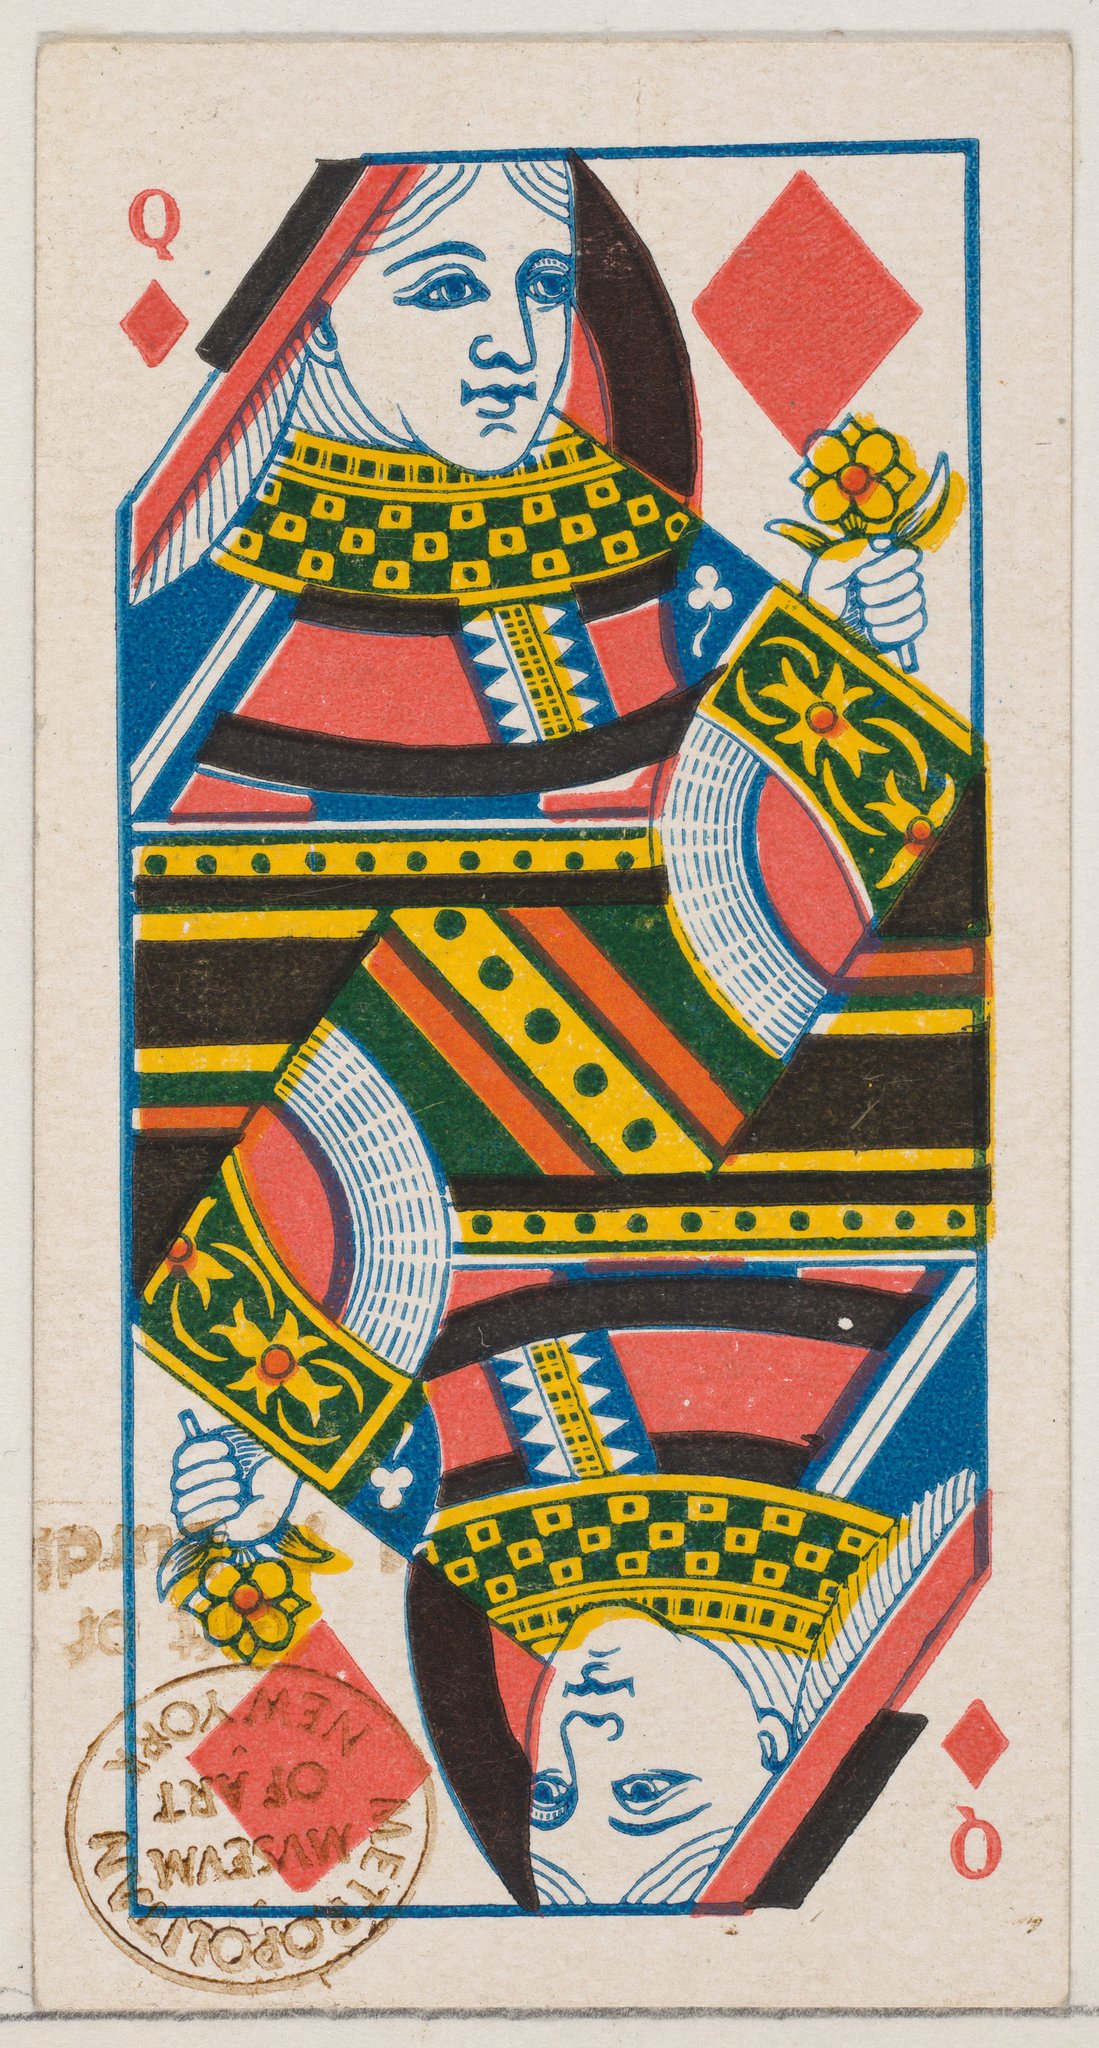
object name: print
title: Queen of Diamonds (red), from the Playing Cards series (N84) for Duke brand cigarettes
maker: w. duke, sons & co.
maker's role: publisher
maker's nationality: american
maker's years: 1870-1920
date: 1888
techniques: color lithograph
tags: playing cards